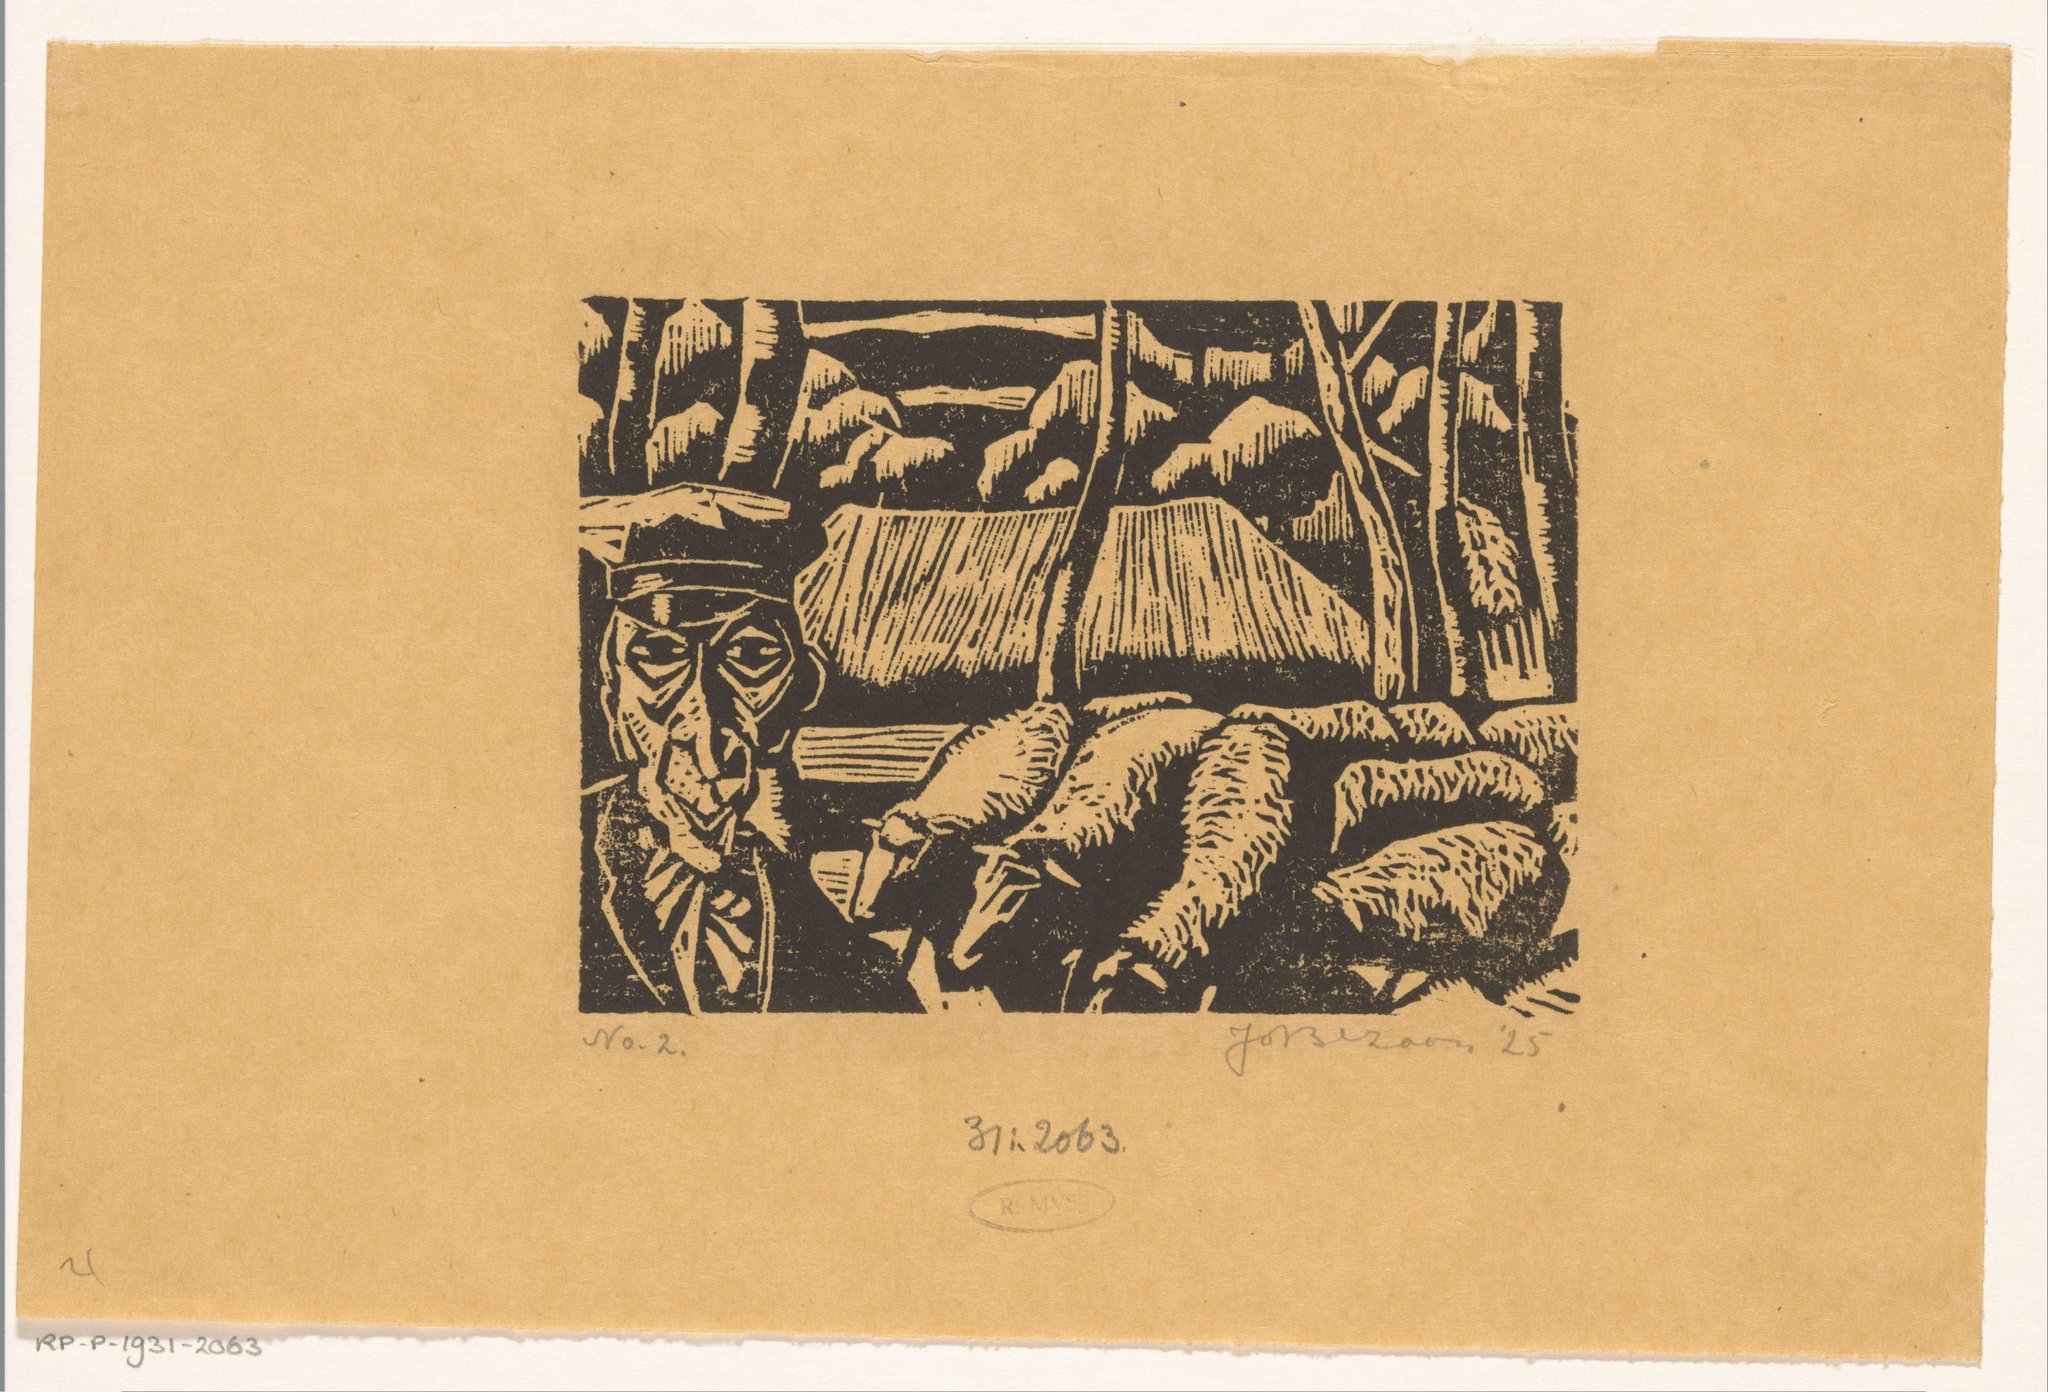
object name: print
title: Herder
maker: jo bezaan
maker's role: draughtsman, print maker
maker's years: 1894-1952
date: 1925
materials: paper, ink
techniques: woodcut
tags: herding, herdsman, herdswoman, shepherd, shepherdess, cowherd, etc., sheep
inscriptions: edition: ‘No. 2’, signature and date: ‘JoBezaan ´25’, collector's mark: Lugt 2228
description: Schouderstuk van een man met pet, met achter hem schapen en een schaapskooi.